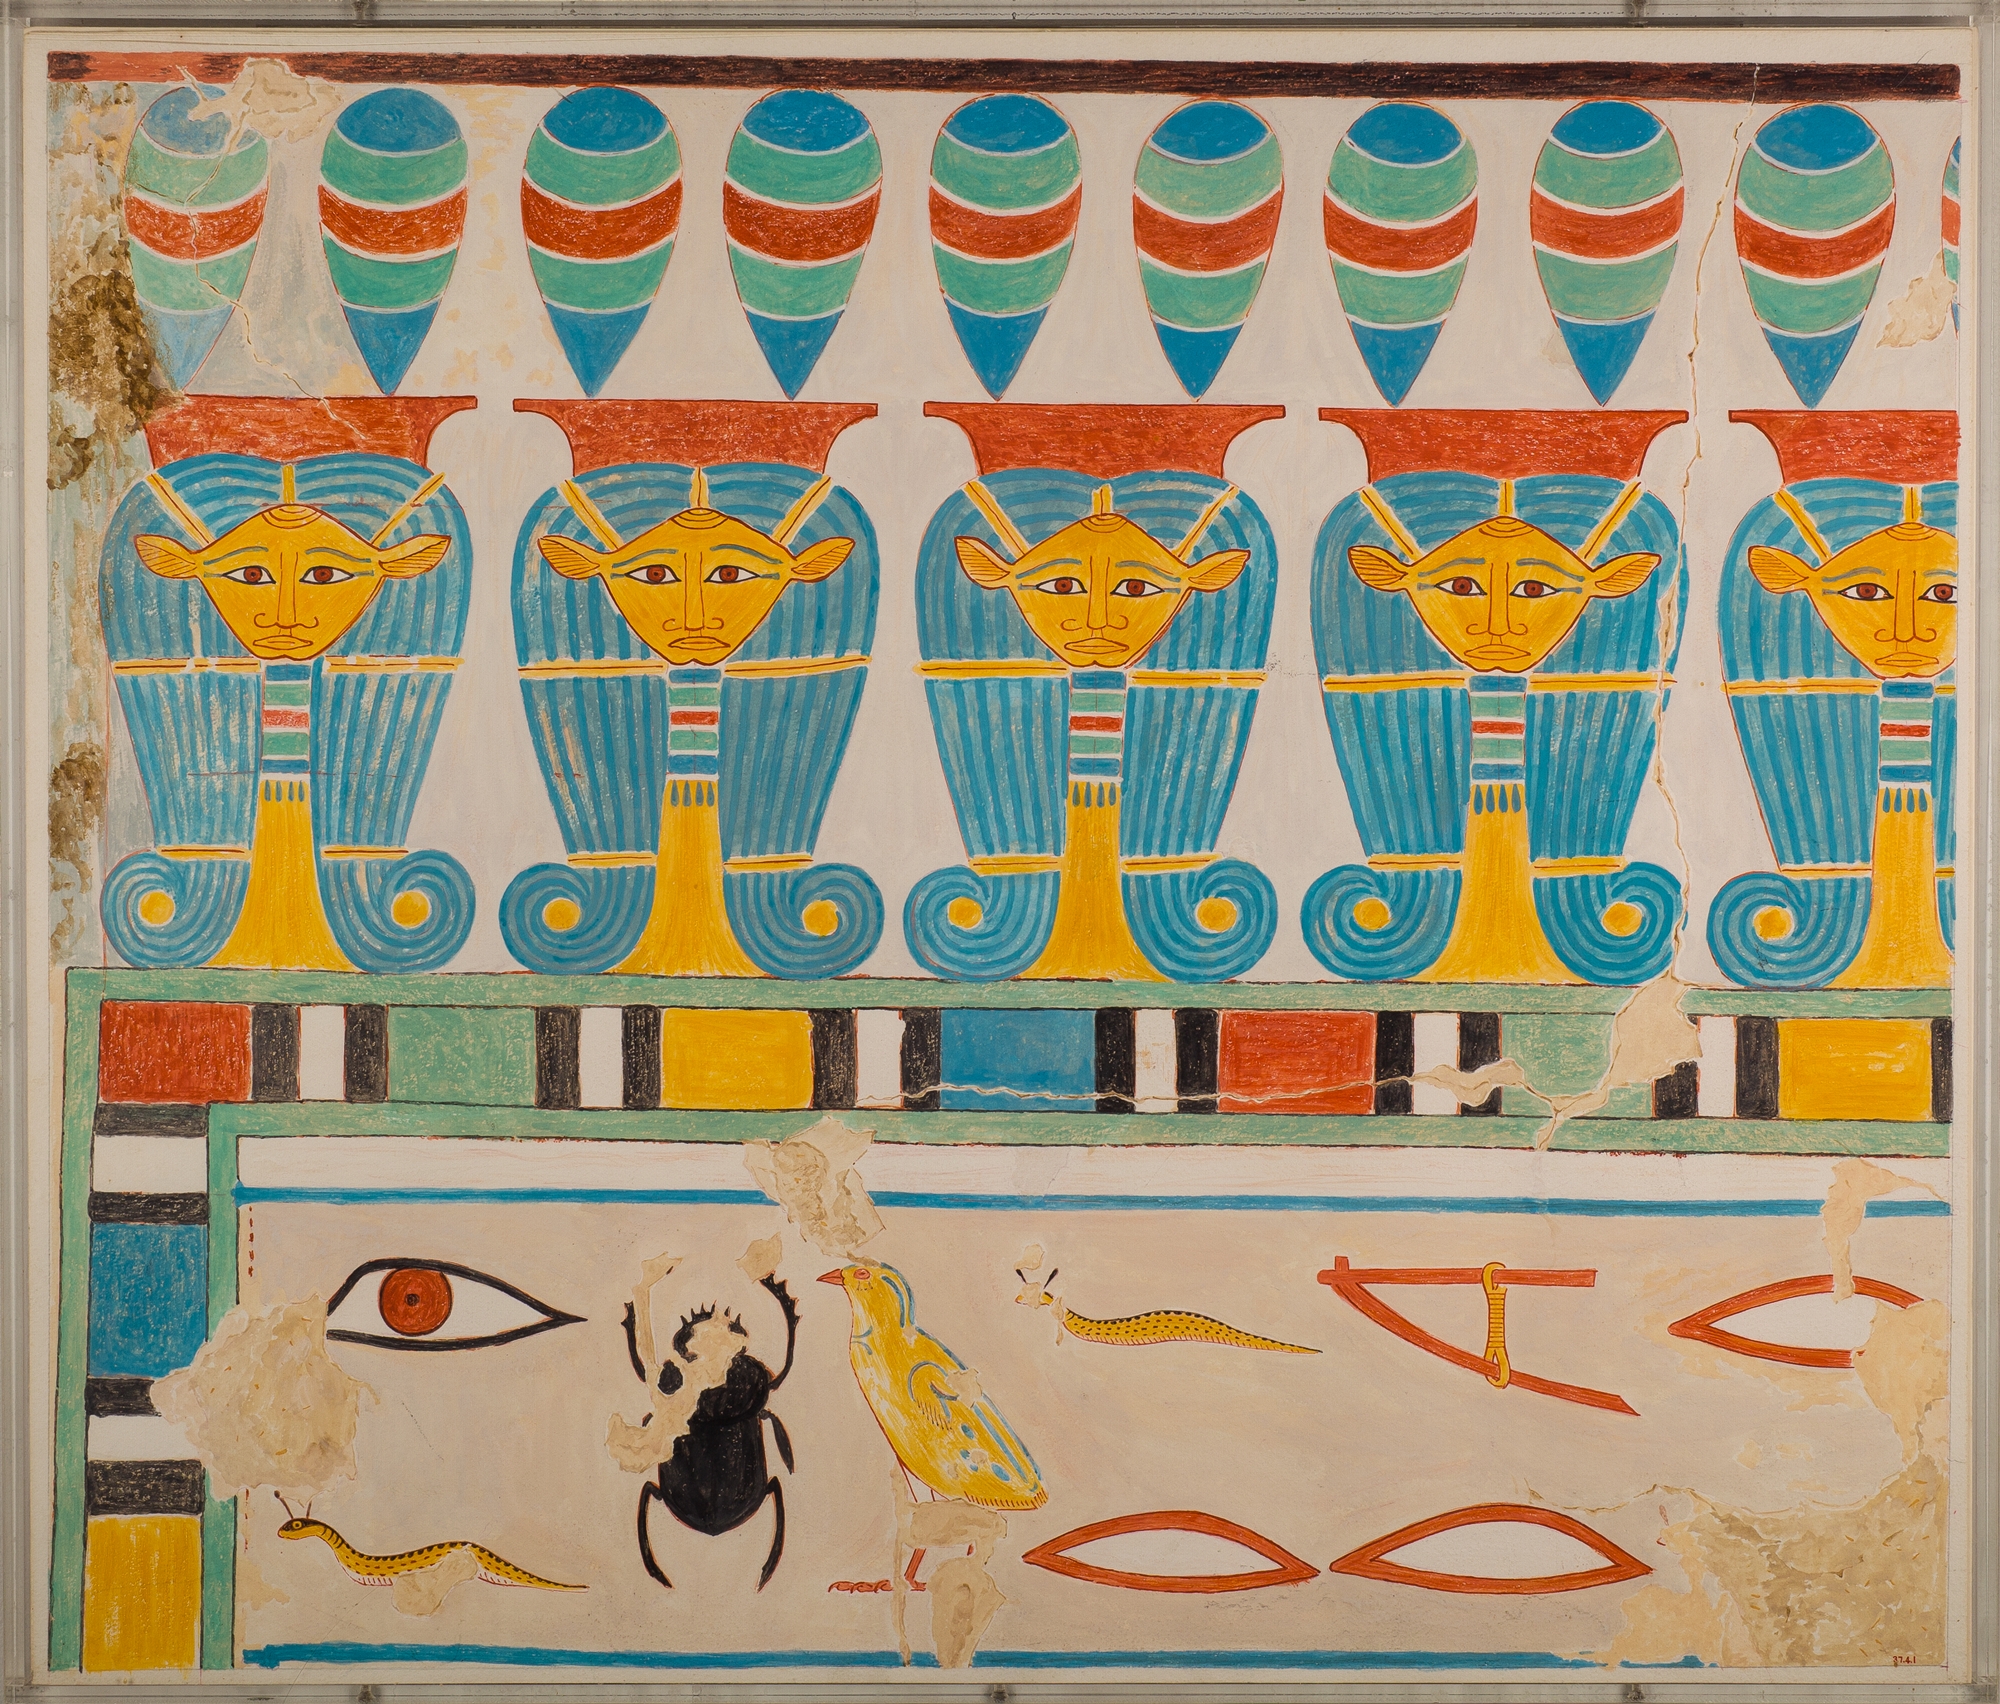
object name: facsimile, restoration, hathor frieze, senenmut tt 71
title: Painted Restoration of the Hathor-Head Frieze in the Tomb of Senenmut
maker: nina de garis davies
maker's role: artist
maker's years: 1881-1965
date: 1479-1458 BCE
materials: paper, paint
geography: egypt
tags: hathor,love-poetry